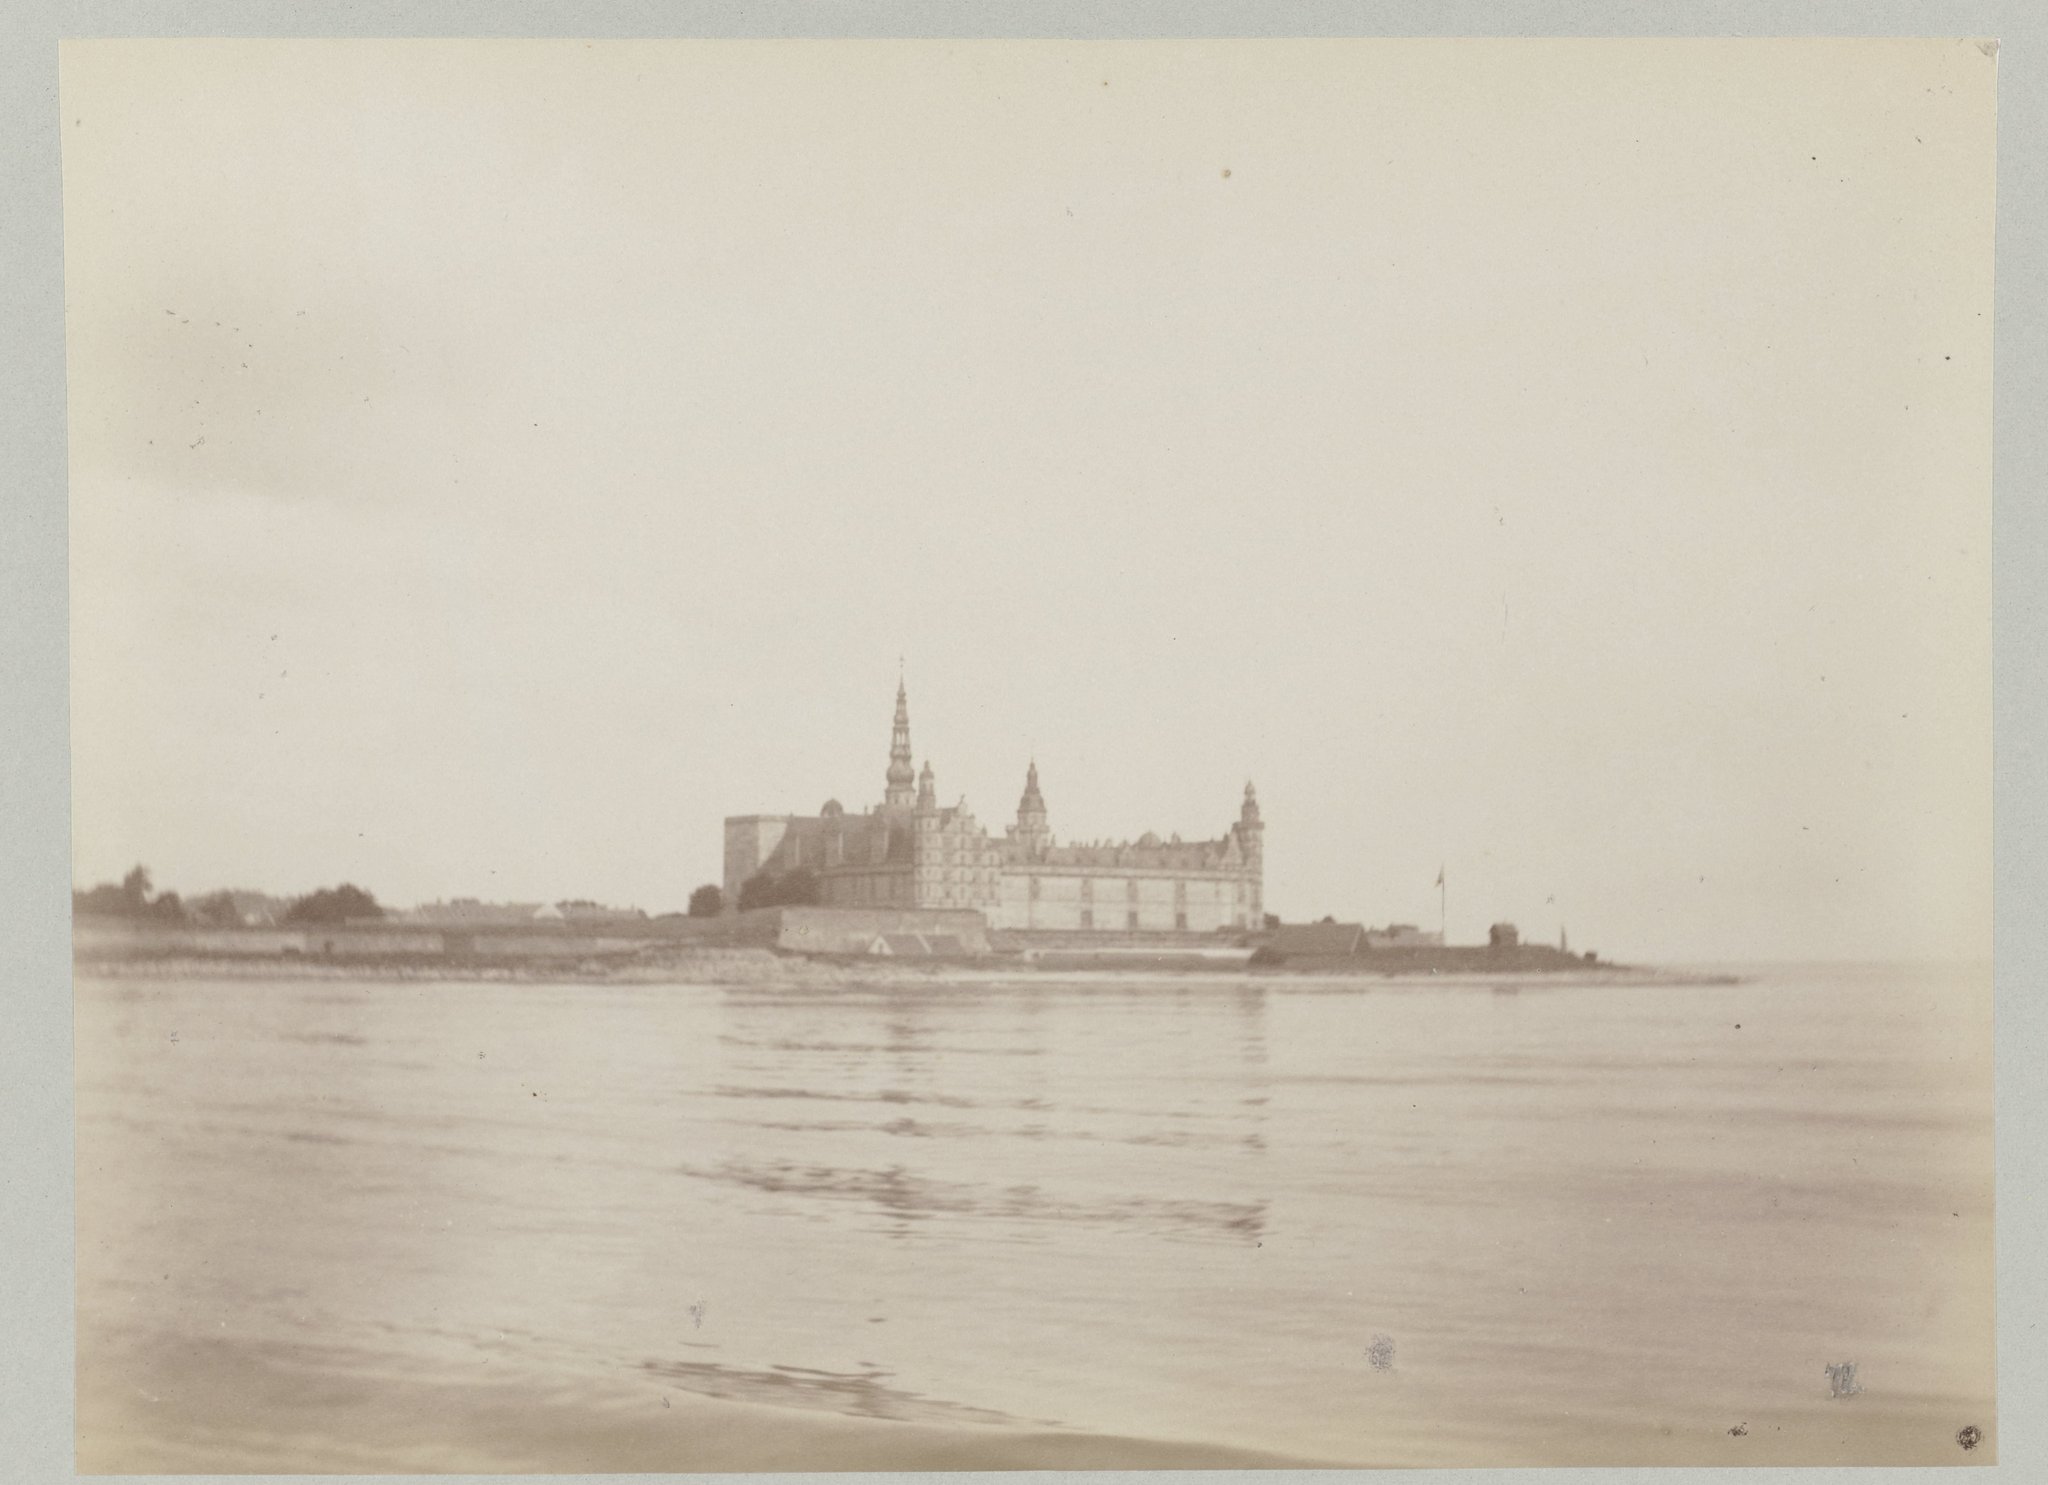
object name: photograph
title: Die Kronenburg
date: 1807-1889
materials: cardboard, paper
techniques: albumen print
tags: wilhelm ii (keizer van duitsland), norway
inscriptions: number: ‘72’, number: ‘3’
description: Maakt onderdeel uit van het album "Erinnerungen an Norwegen im Juli 1889"